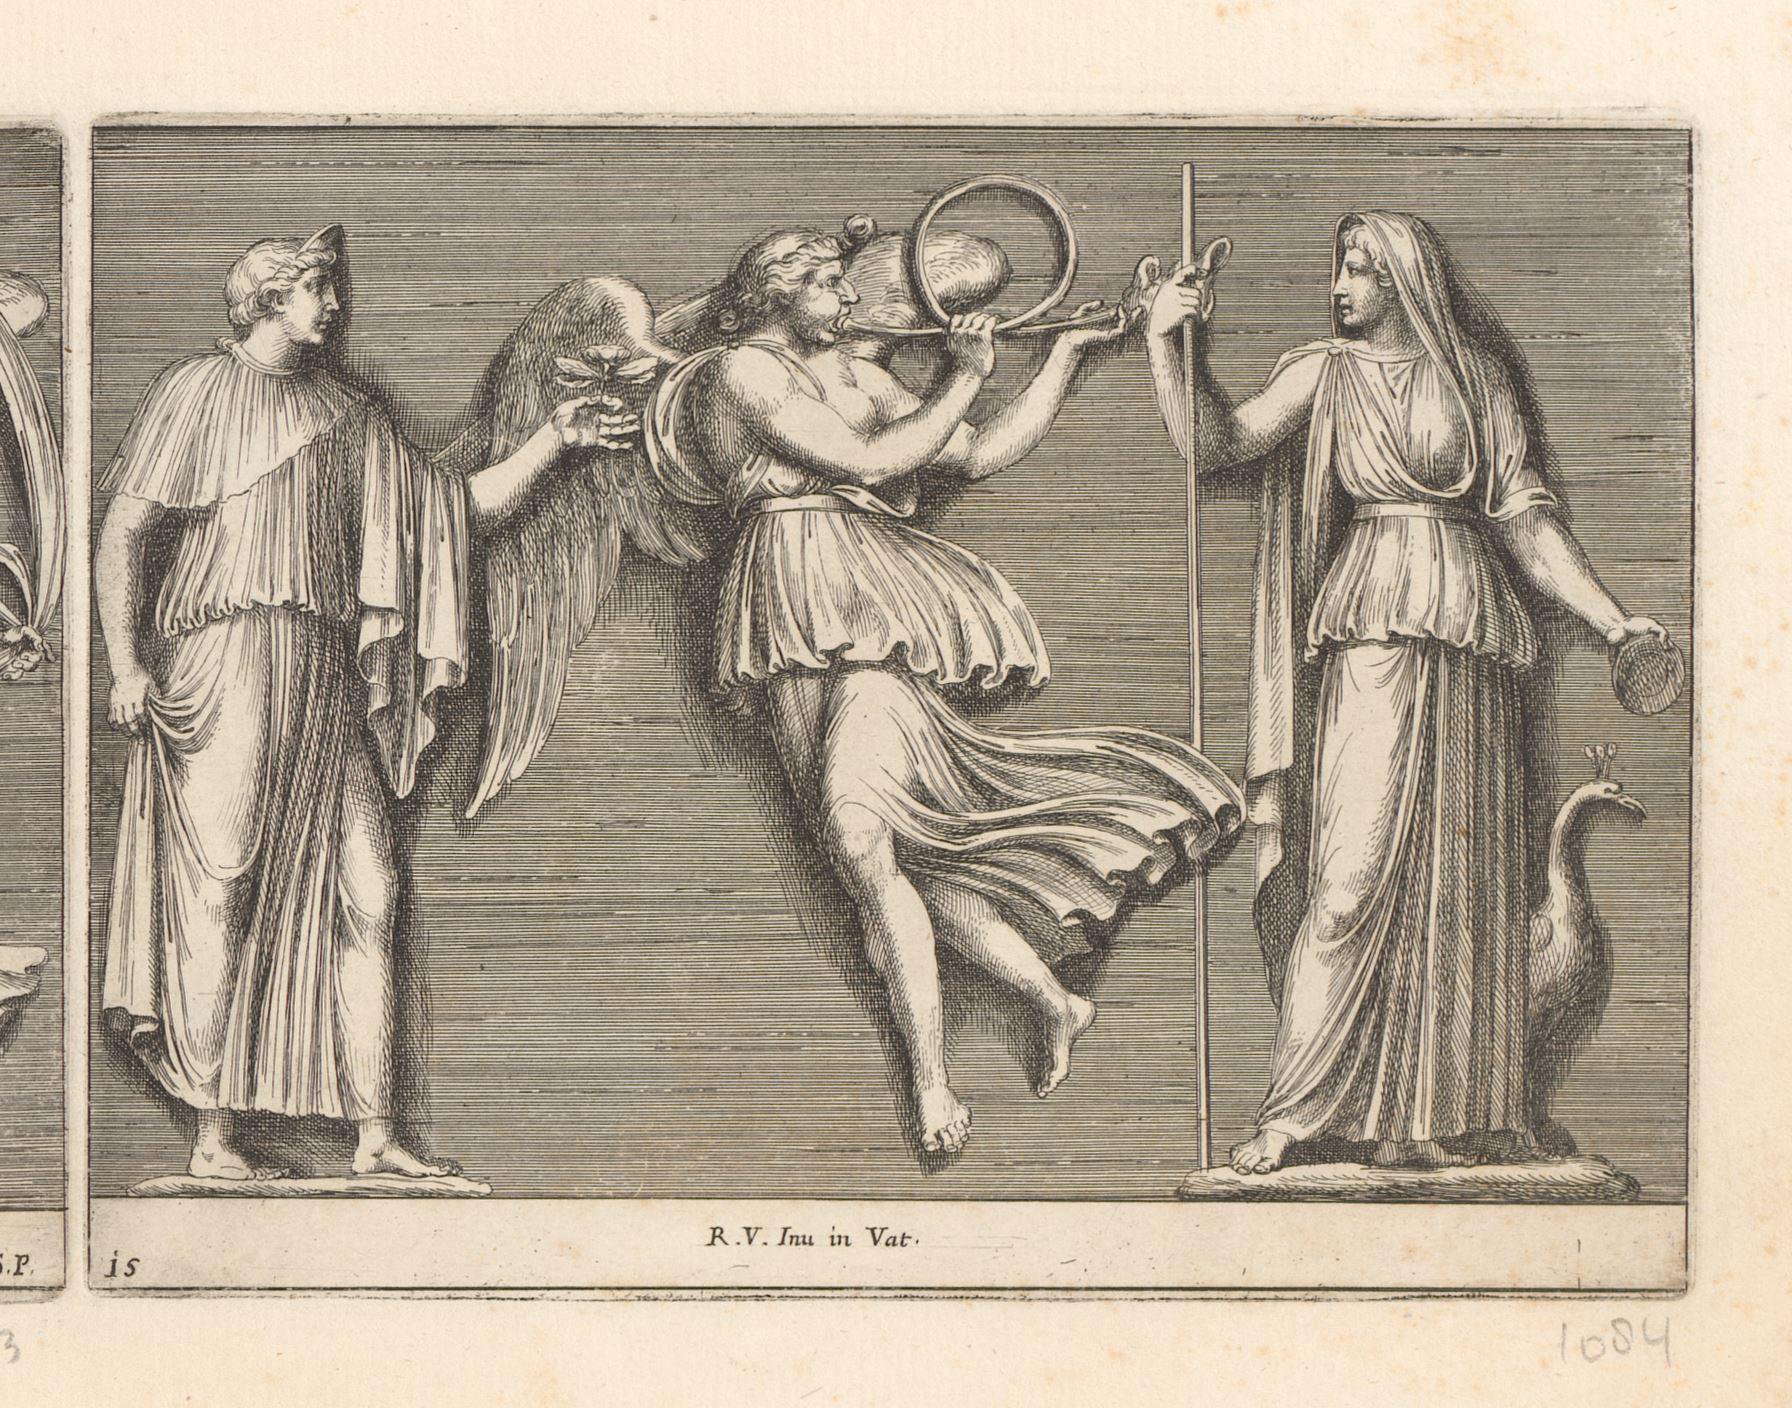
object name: album leaf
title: Twee vrouwenfiguren en een engel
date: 1645-1700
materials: paper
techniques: engraving, etching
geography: vatican city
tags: adult woman, angels singing, making music, angels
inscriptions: number: ‘43’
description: Twee vrouwenfiguren in toga's, een met een roos en de ander met een staf en een pauw, kijken naar een engel die op een trompet blaast. Prent maakt deel uit van een album.